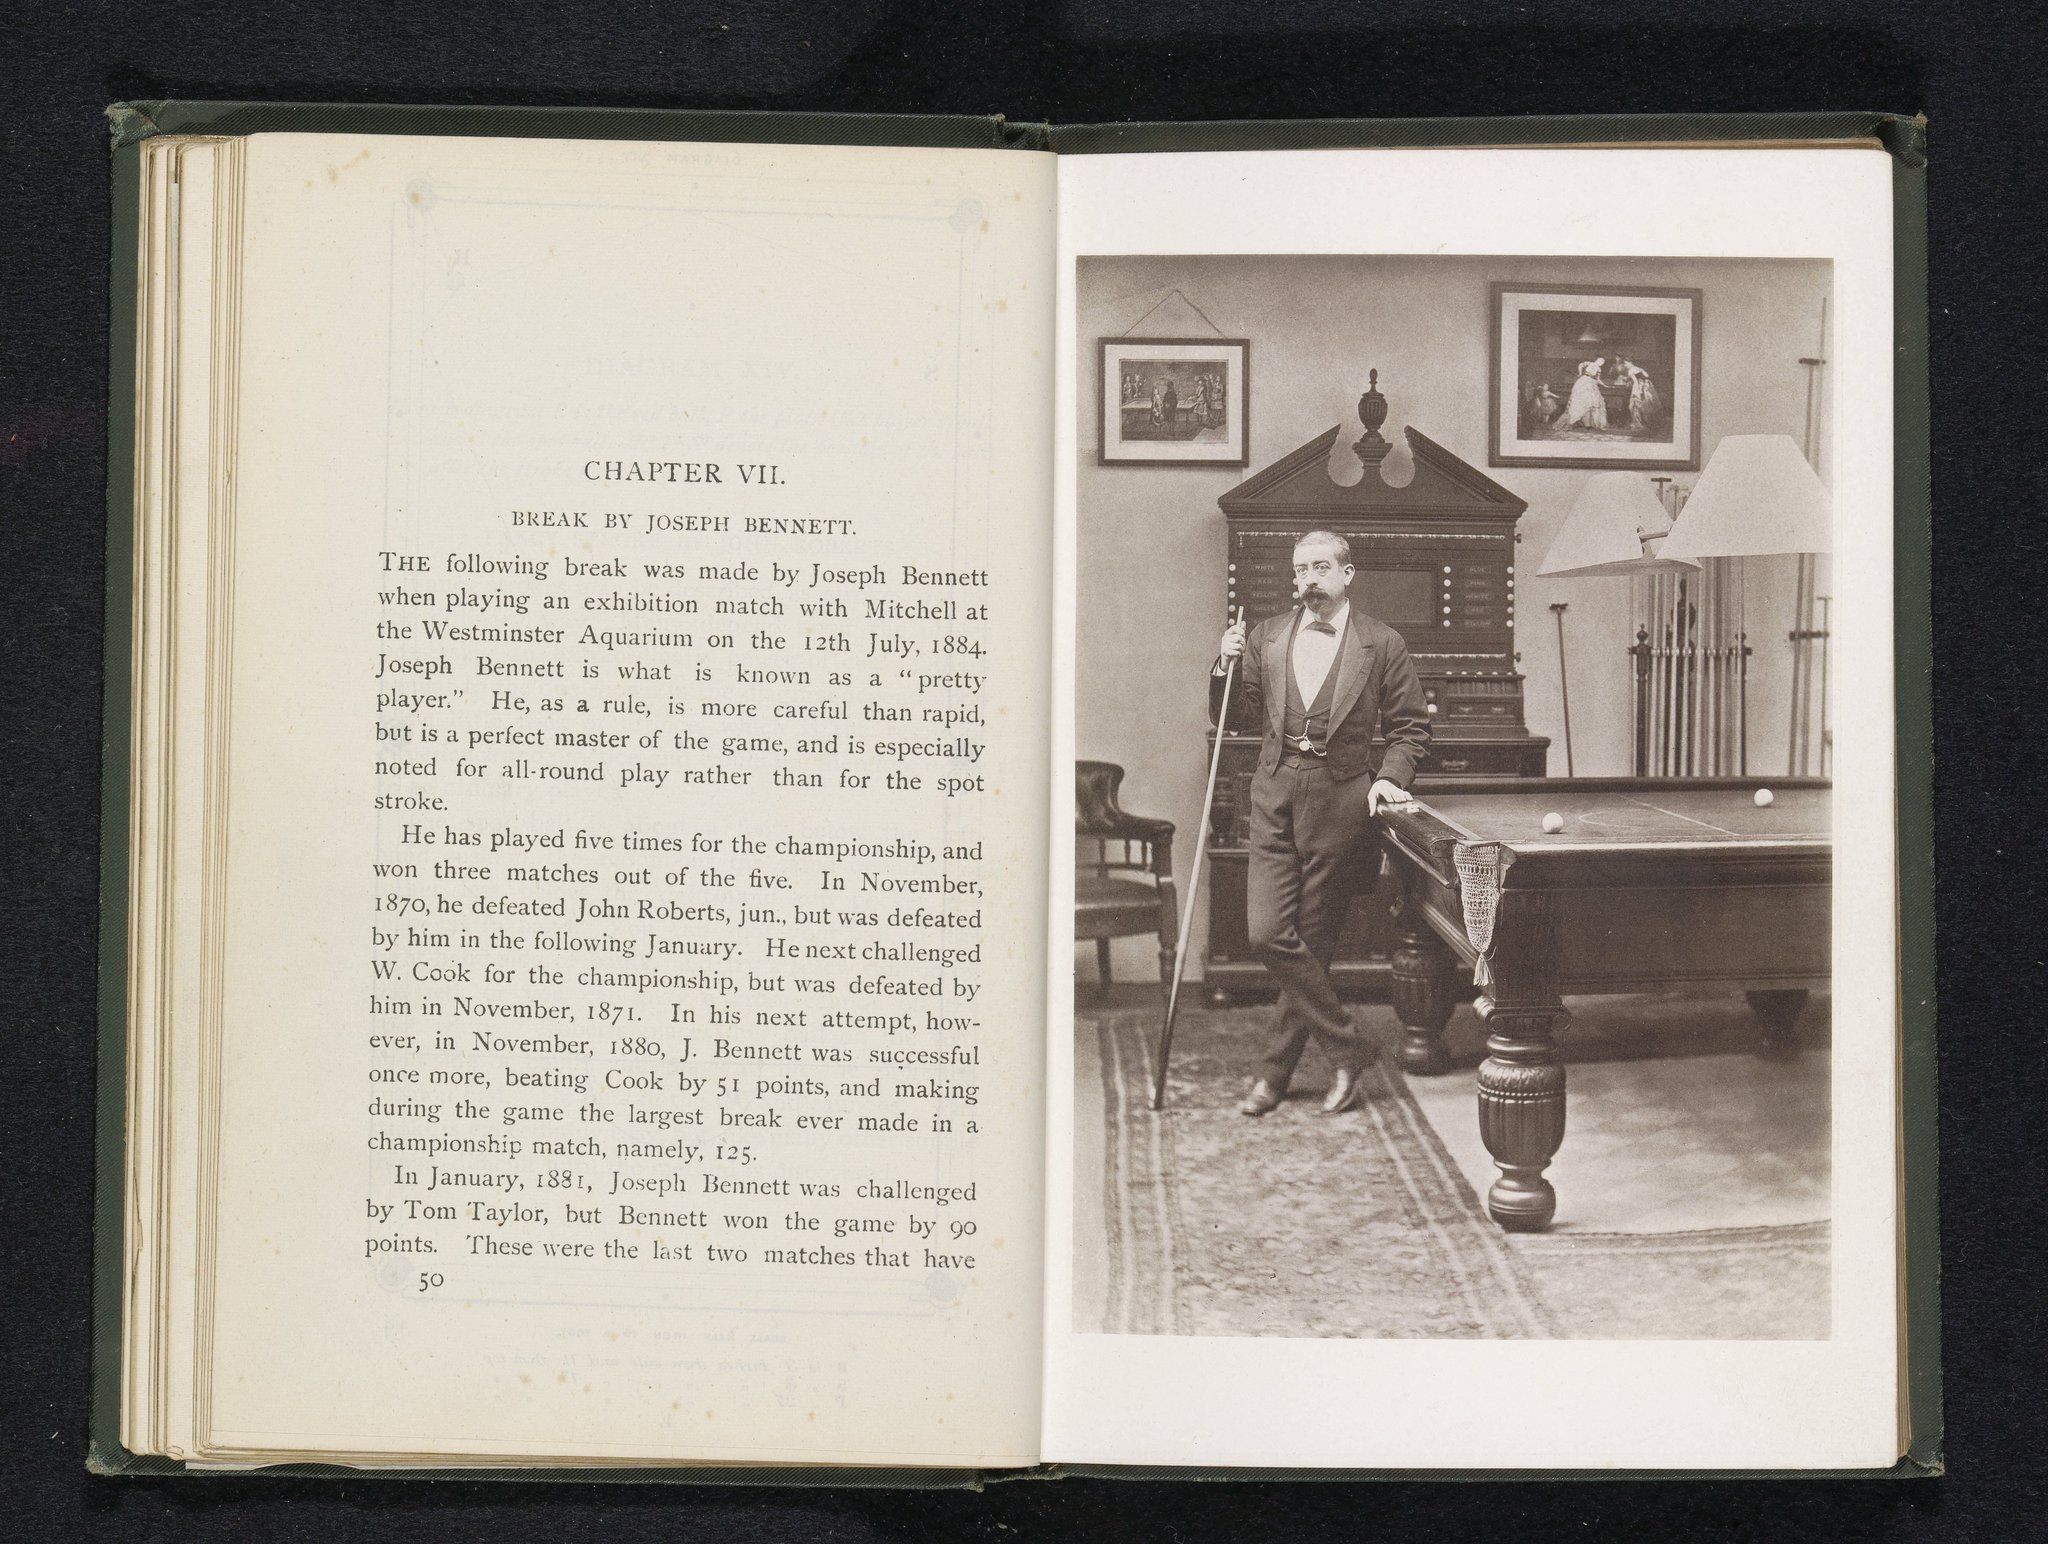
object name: page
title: Man met een keu in de hand naast een biljarttafel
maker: Anonymous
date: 1875-1885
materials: paper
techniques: photograph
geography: great britain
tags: billiards, billiards (+ sportsman, player, etc.), interior ~ representation of a building